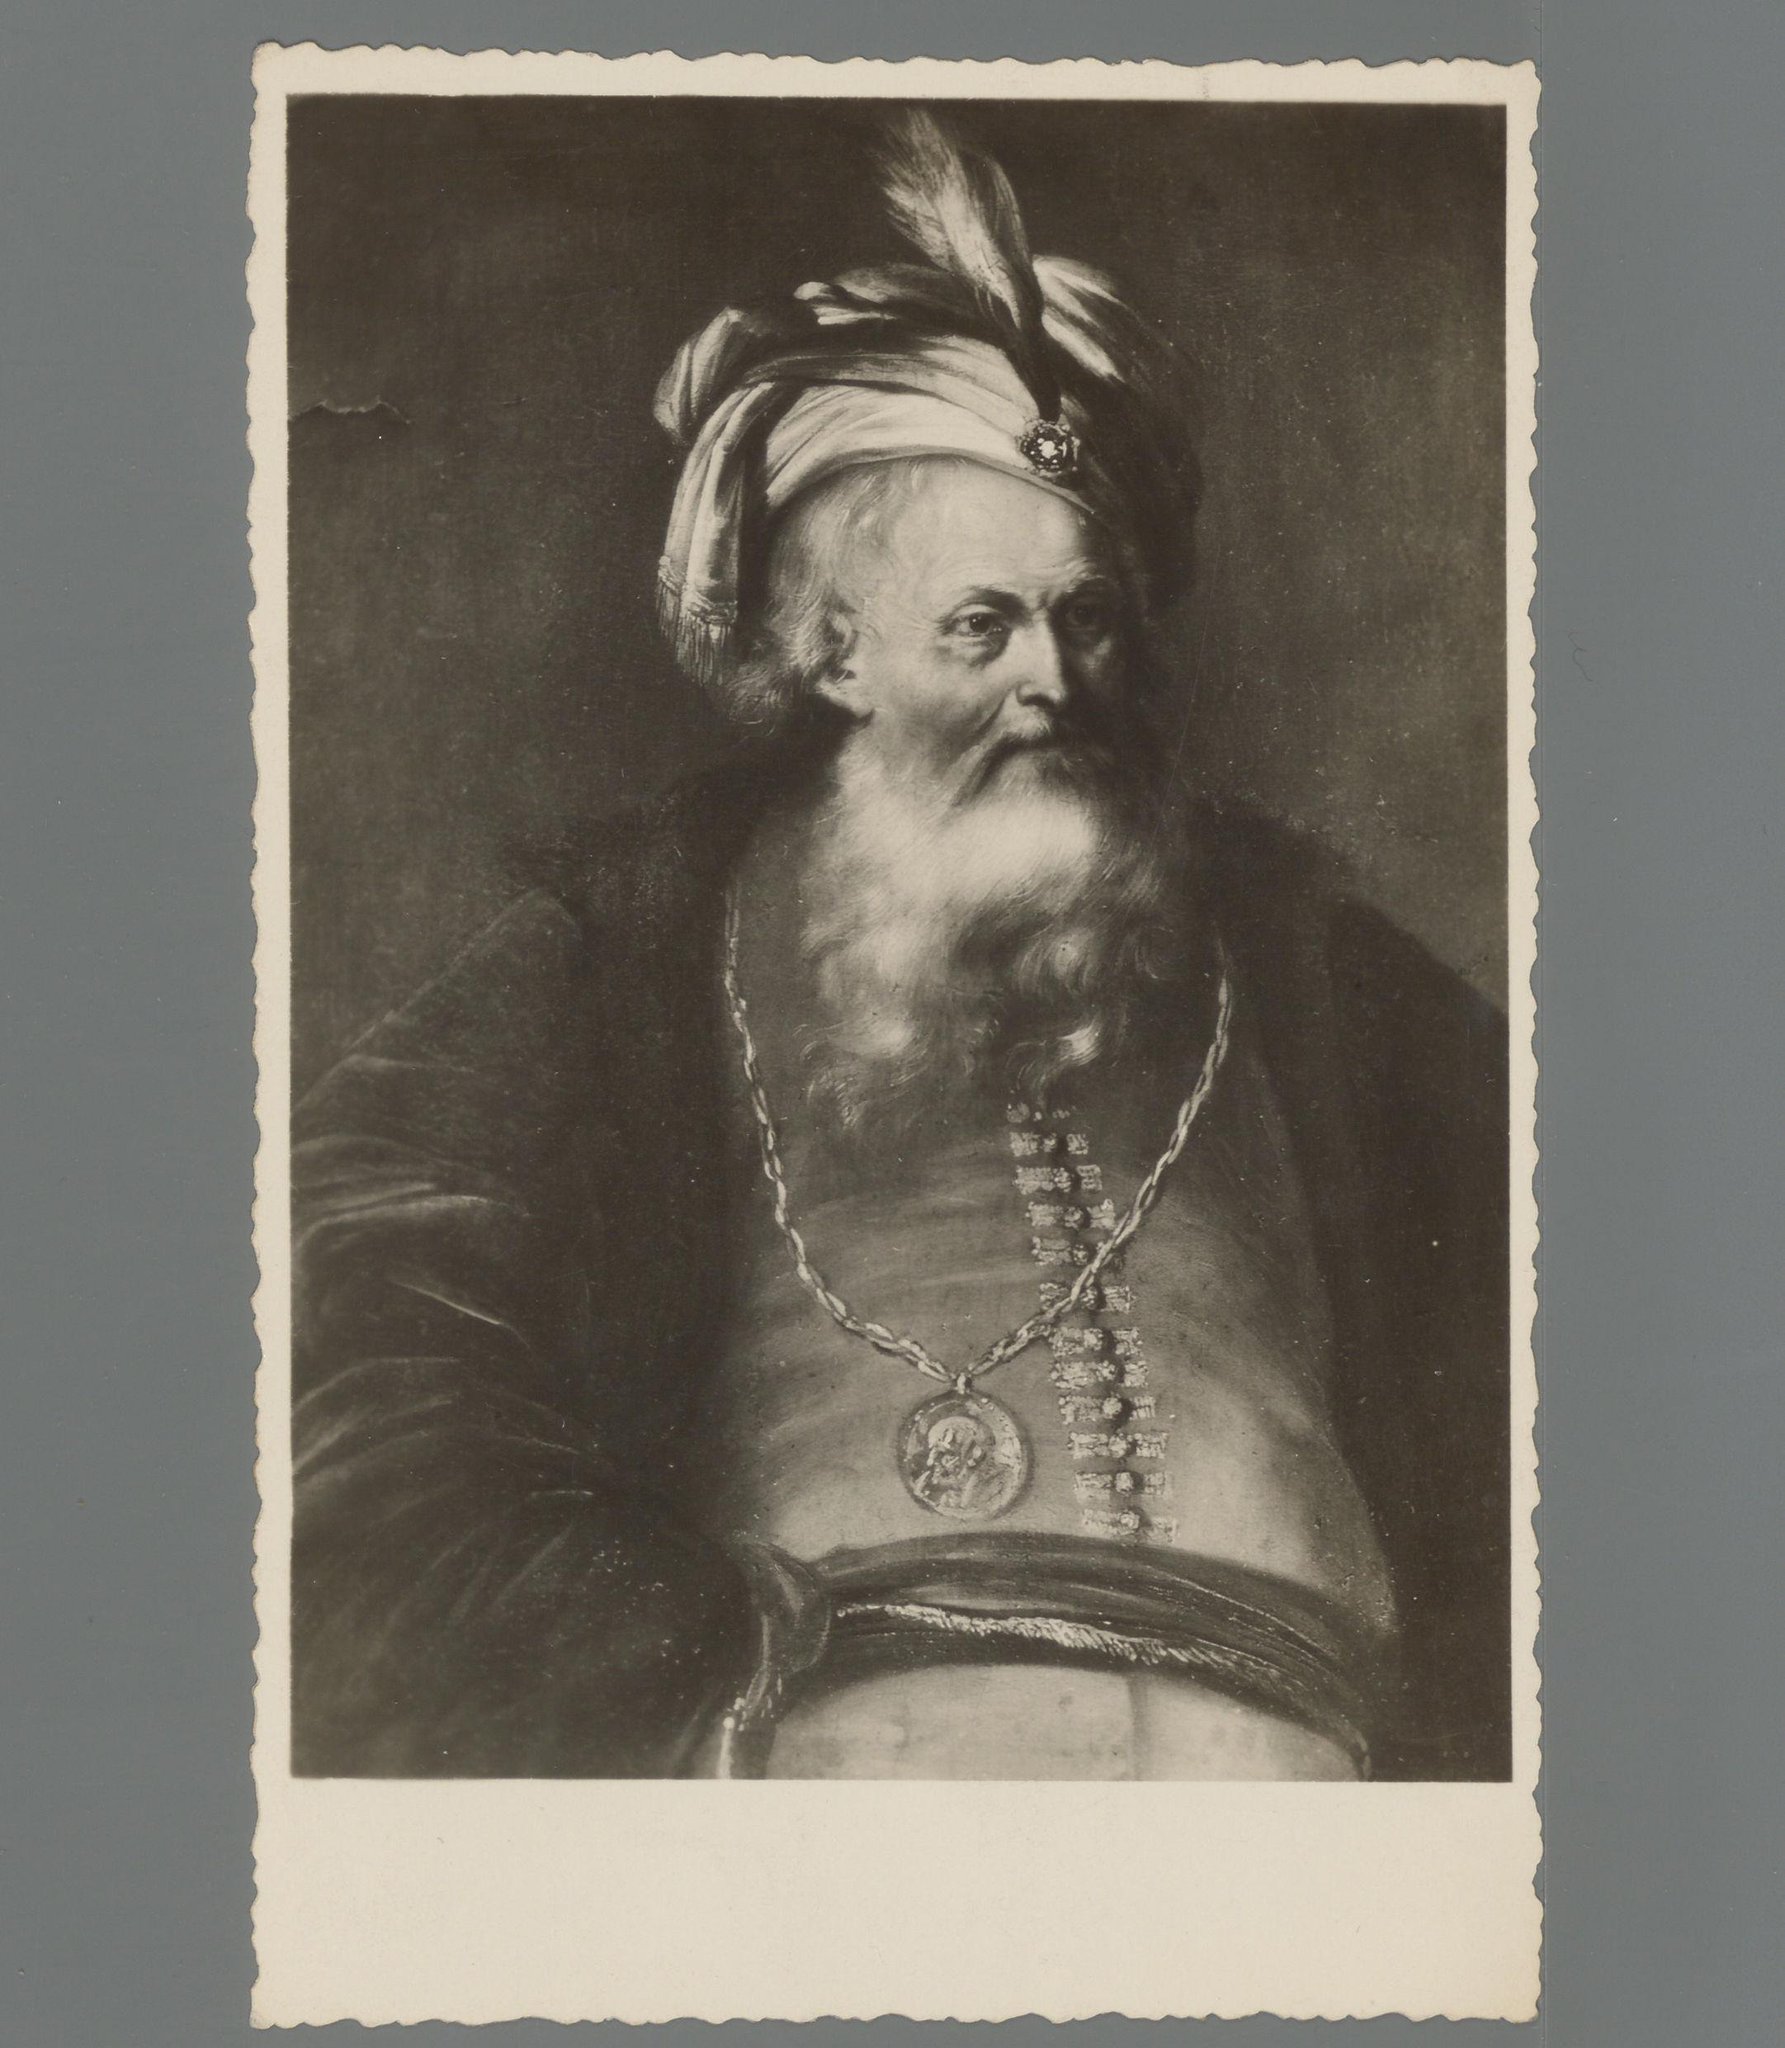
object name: ansichtkaart, prentbriefkaart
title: Portret van een onbekende man met tulband en een ketting op de borst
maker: Anonymous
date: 1906-1930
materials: photographic support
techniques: photography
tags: historical persons not known by name